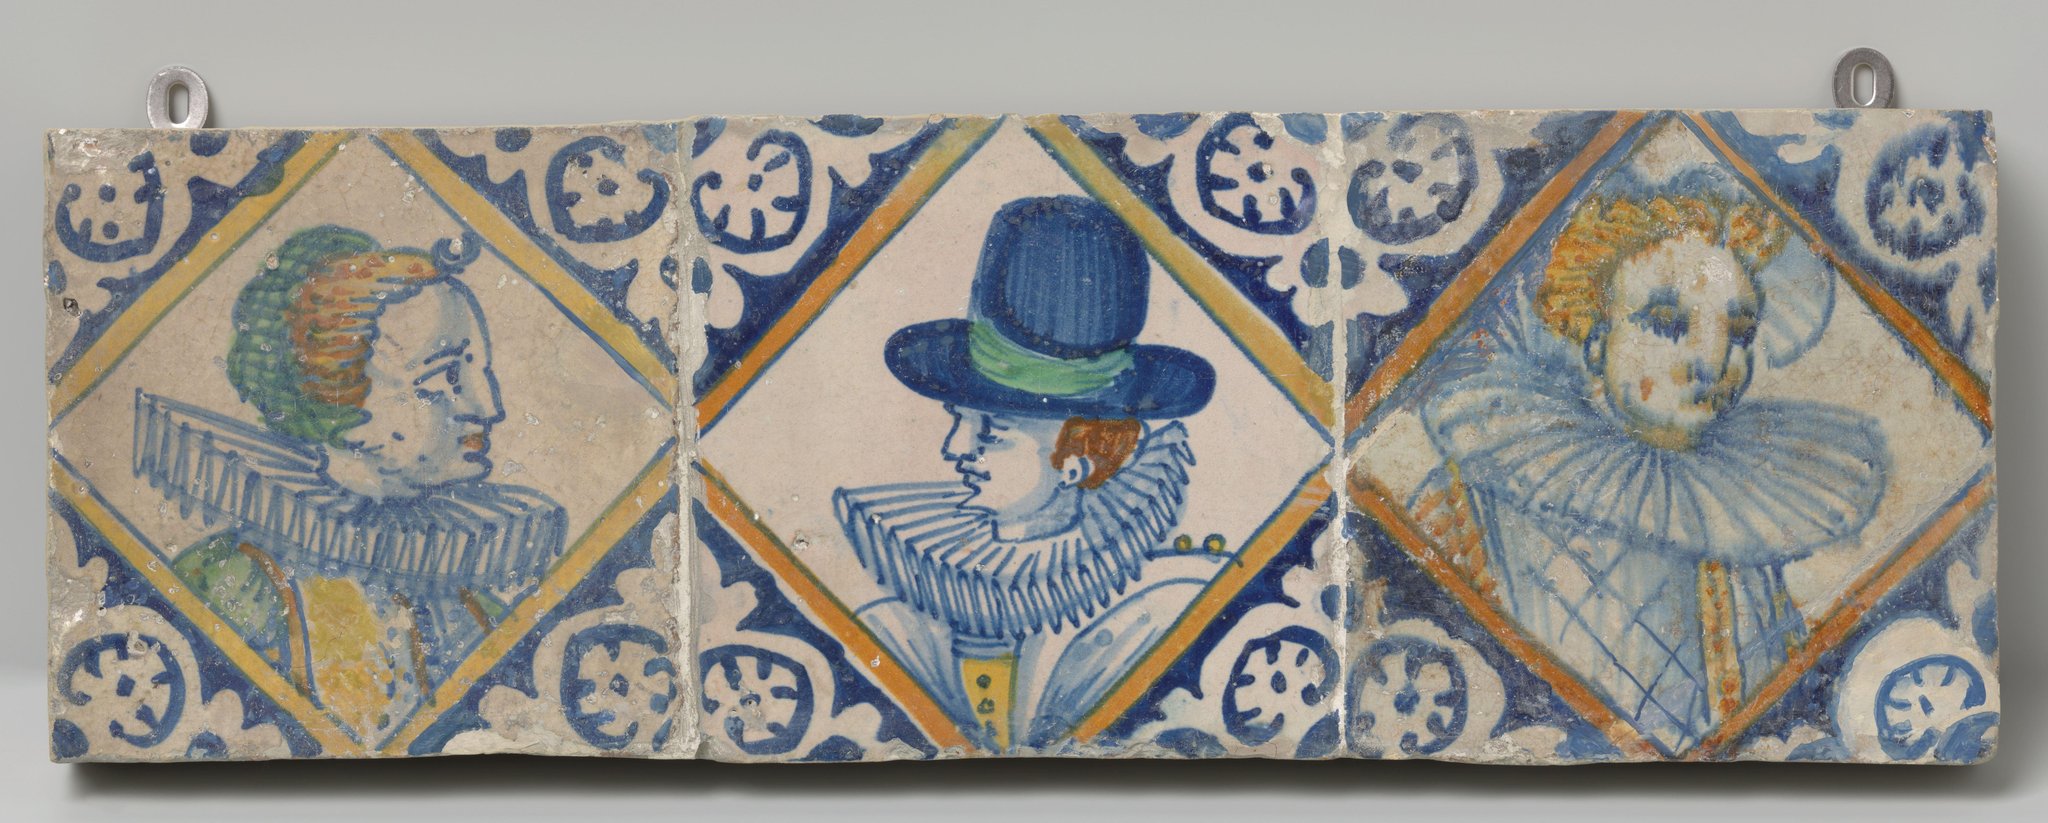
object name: tile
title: Tegel met portret van een man met plooikraag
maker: Anonymous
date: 1580-1625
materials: earthenware, glaze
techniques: maiolica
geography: netherlands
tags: neck-gear ~ clothing (with name), anonymous historical person portrayed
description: Tegel met een veelkleurig (blauw, oranje, geel en groen) portret van een man met hoed en plooikraag binnen een kwadraat met in de hoeken, ornament in vultechniek.